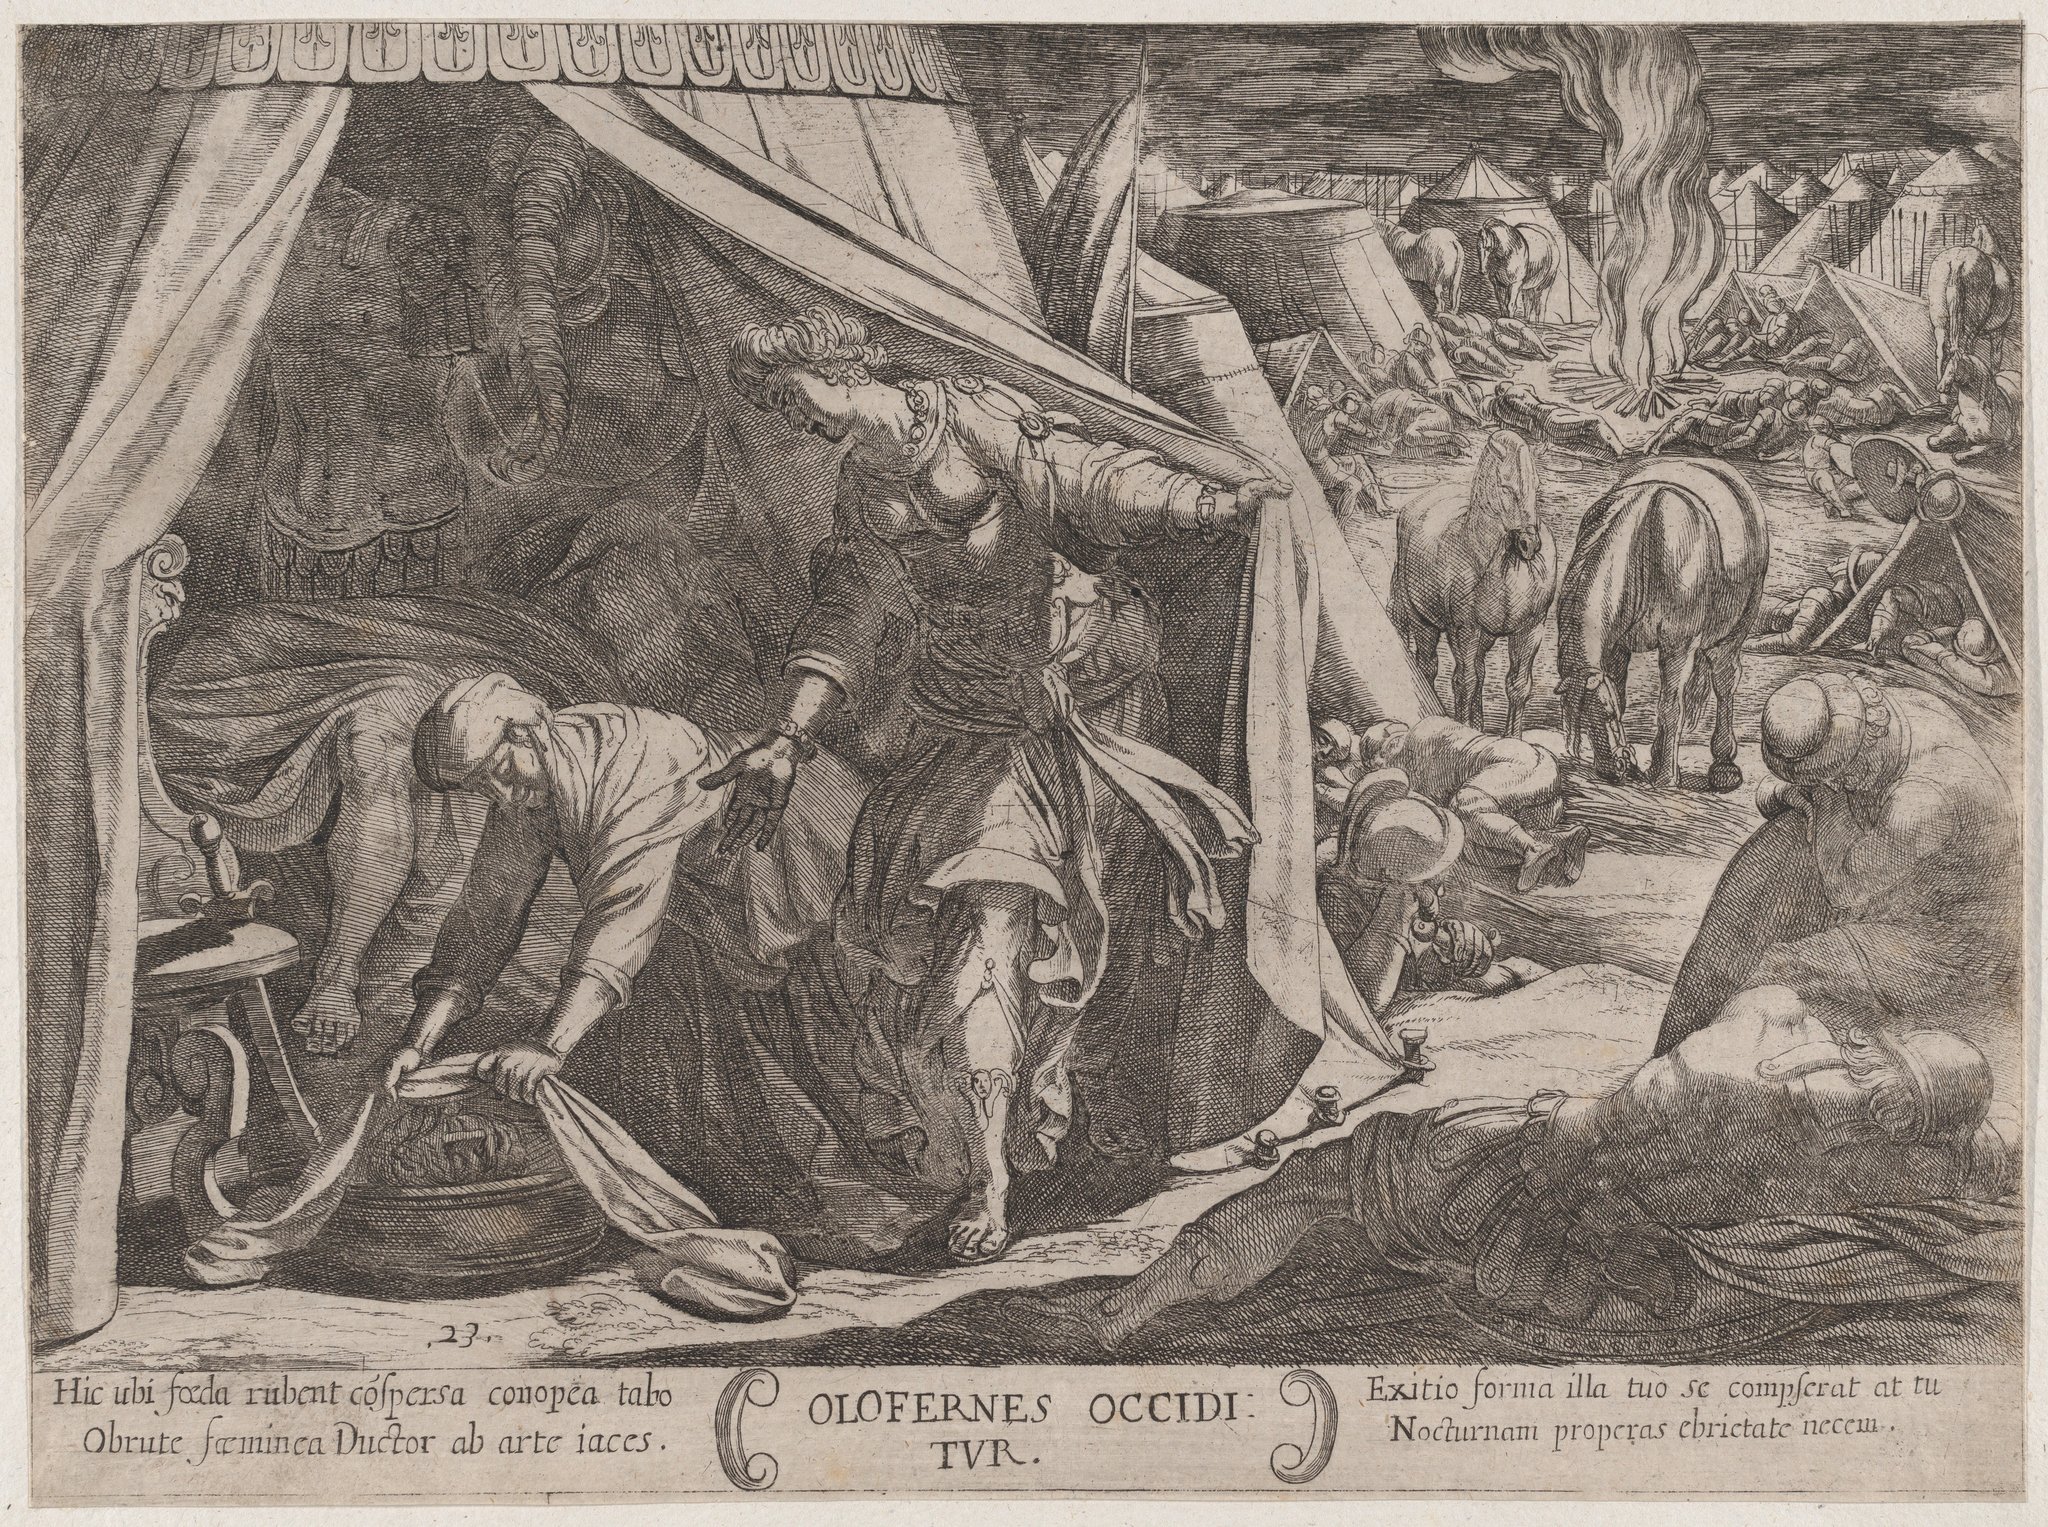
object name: print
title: Plate 23: Judith and Holofernes, from "The Battles of the Old Testament"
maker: antonio tempesta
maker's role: artist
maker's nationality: italian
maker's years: 1555-1630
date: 1590-1610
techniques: etching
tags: tents,horses,fire,holofernes,judith